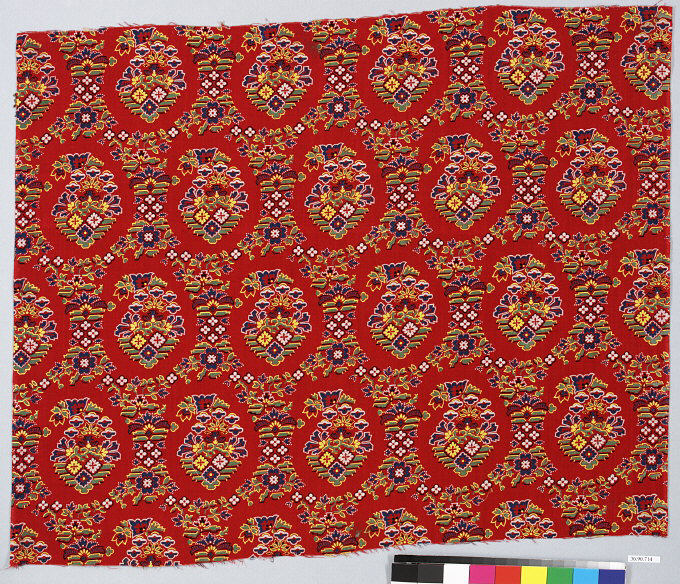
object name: piece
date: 1867-1900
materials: cotton